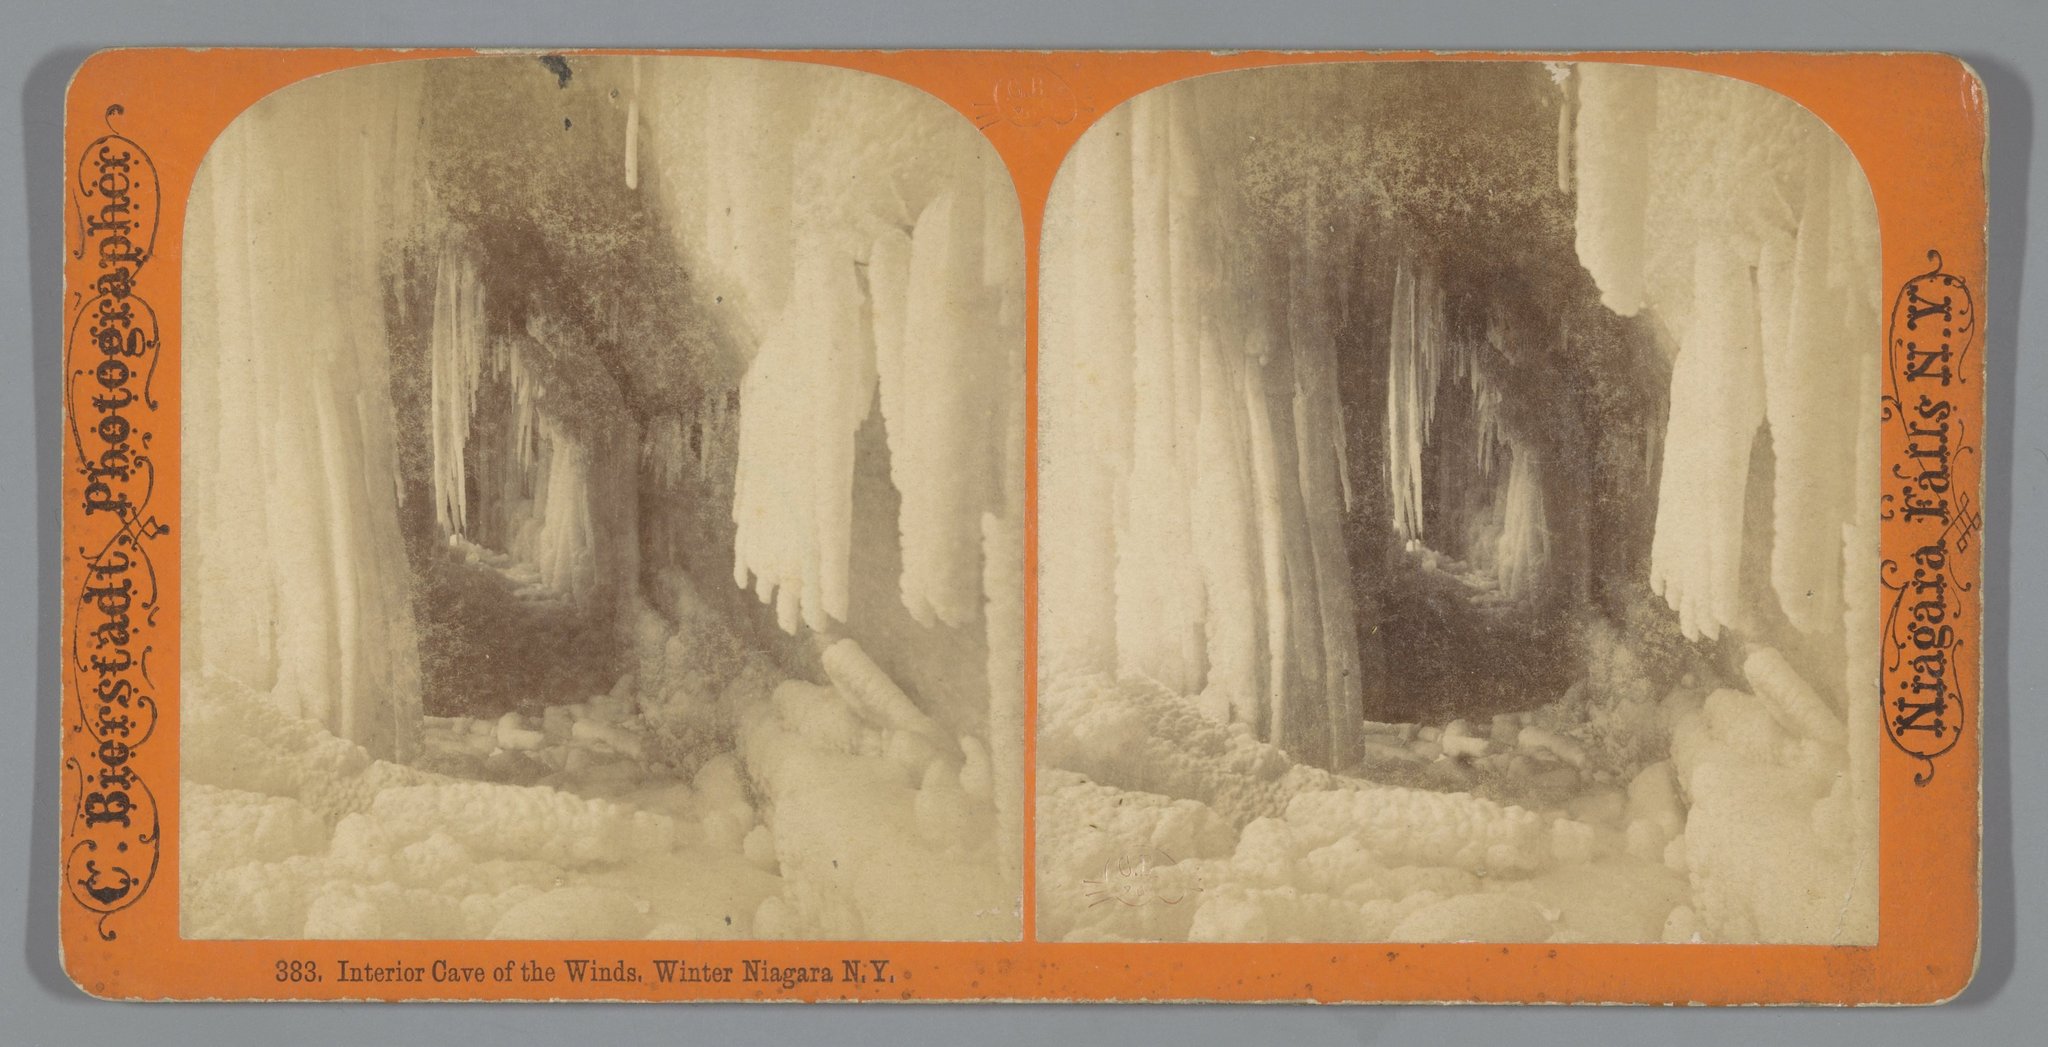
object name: stereograph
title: IJspegels in de Cave of the Winds, Niagarawatervallen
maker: charles bierstadt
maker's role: publisher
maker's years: 1819-1903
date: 1867-1891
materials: cardboard, paper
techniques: albumen print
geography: niagara falls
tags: stalactitic cave, icicle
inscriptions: inscription: ‘Niagara Falls N.Y.’, initials: ‘C.B.’, number: ‘383’